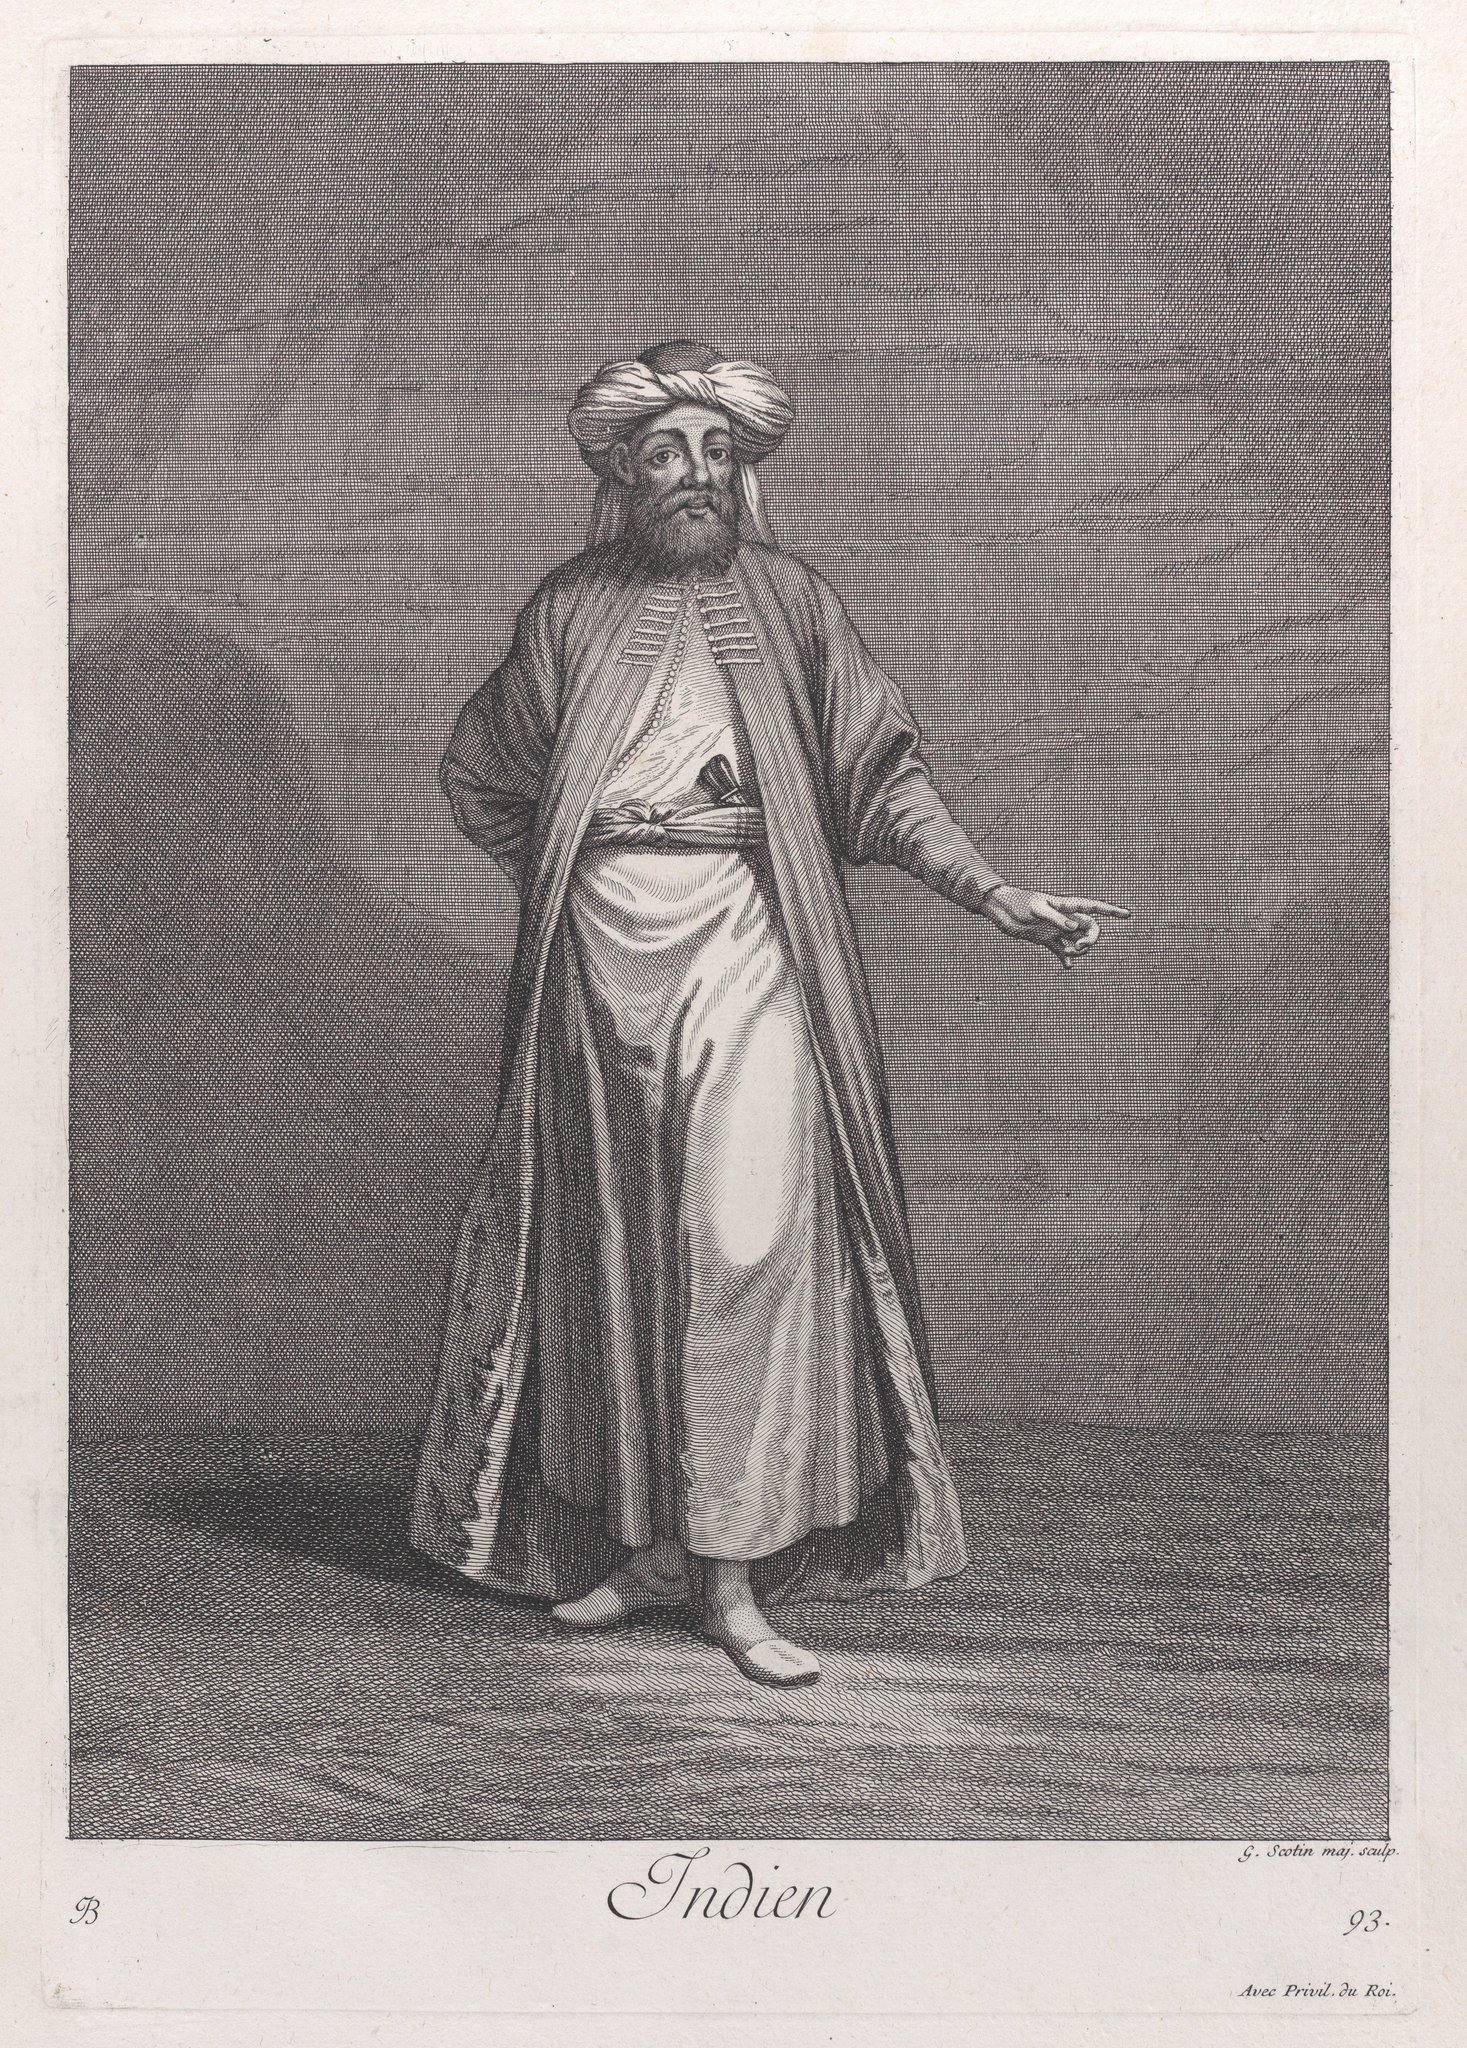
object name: print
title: Indien, plate 93 from "Recueil de cent estampes représentent differentes nations du Levant"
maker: jean baptiste vanmour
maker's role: artist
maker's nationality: french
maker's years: 1671-1737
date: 1714-1715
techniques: engraving, etching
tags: men